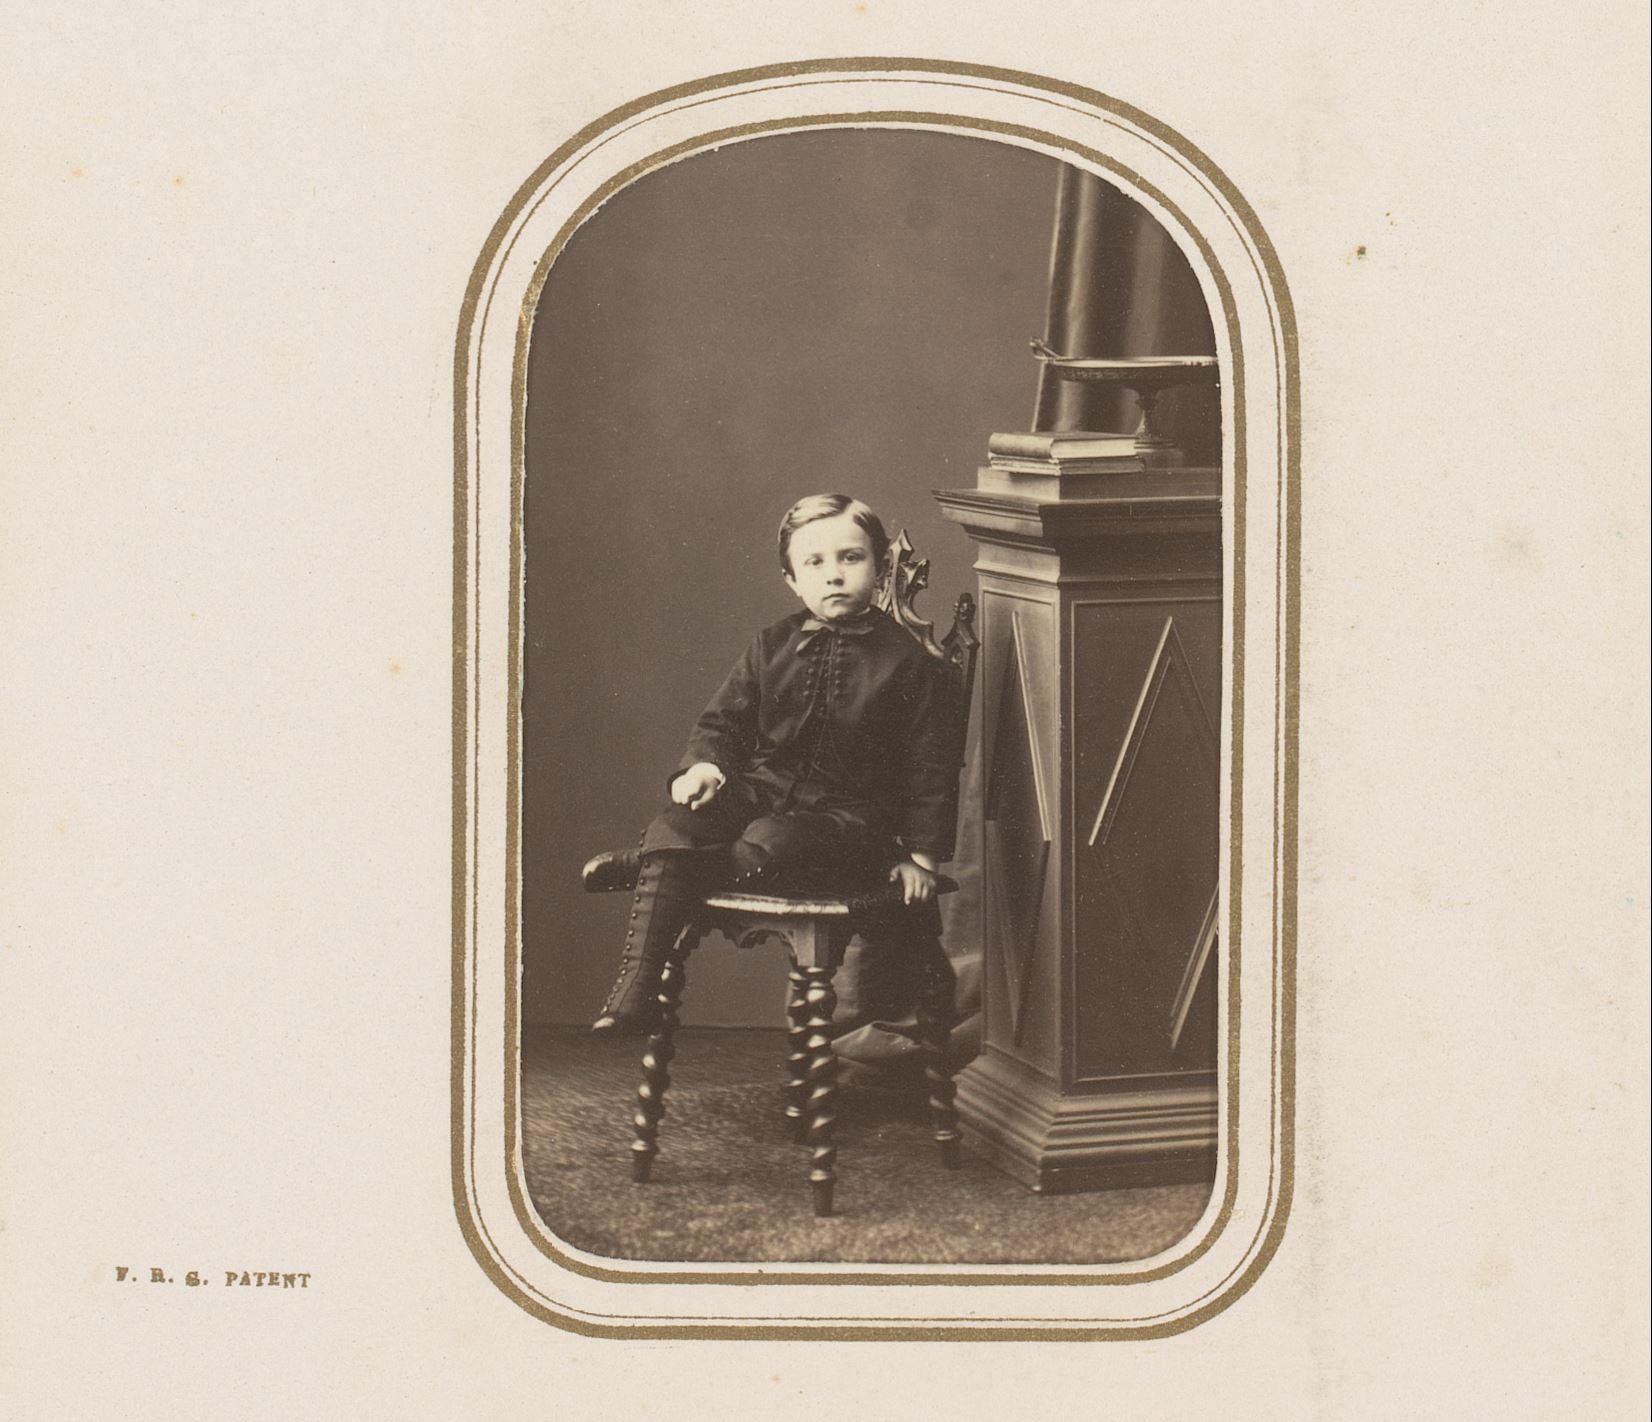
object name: photograph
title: Portret van een kind, zittend op een stoel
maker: alexandre ken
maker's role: fotograaf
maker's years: 1828-1874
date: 1850-1890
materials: cardboard, photographic support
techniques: albumen print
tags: sitting figure, child, historical persons, chair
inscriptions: inscription: ‘A. Ken. Photographe/ Boulev Montmartre 10/ Paris’